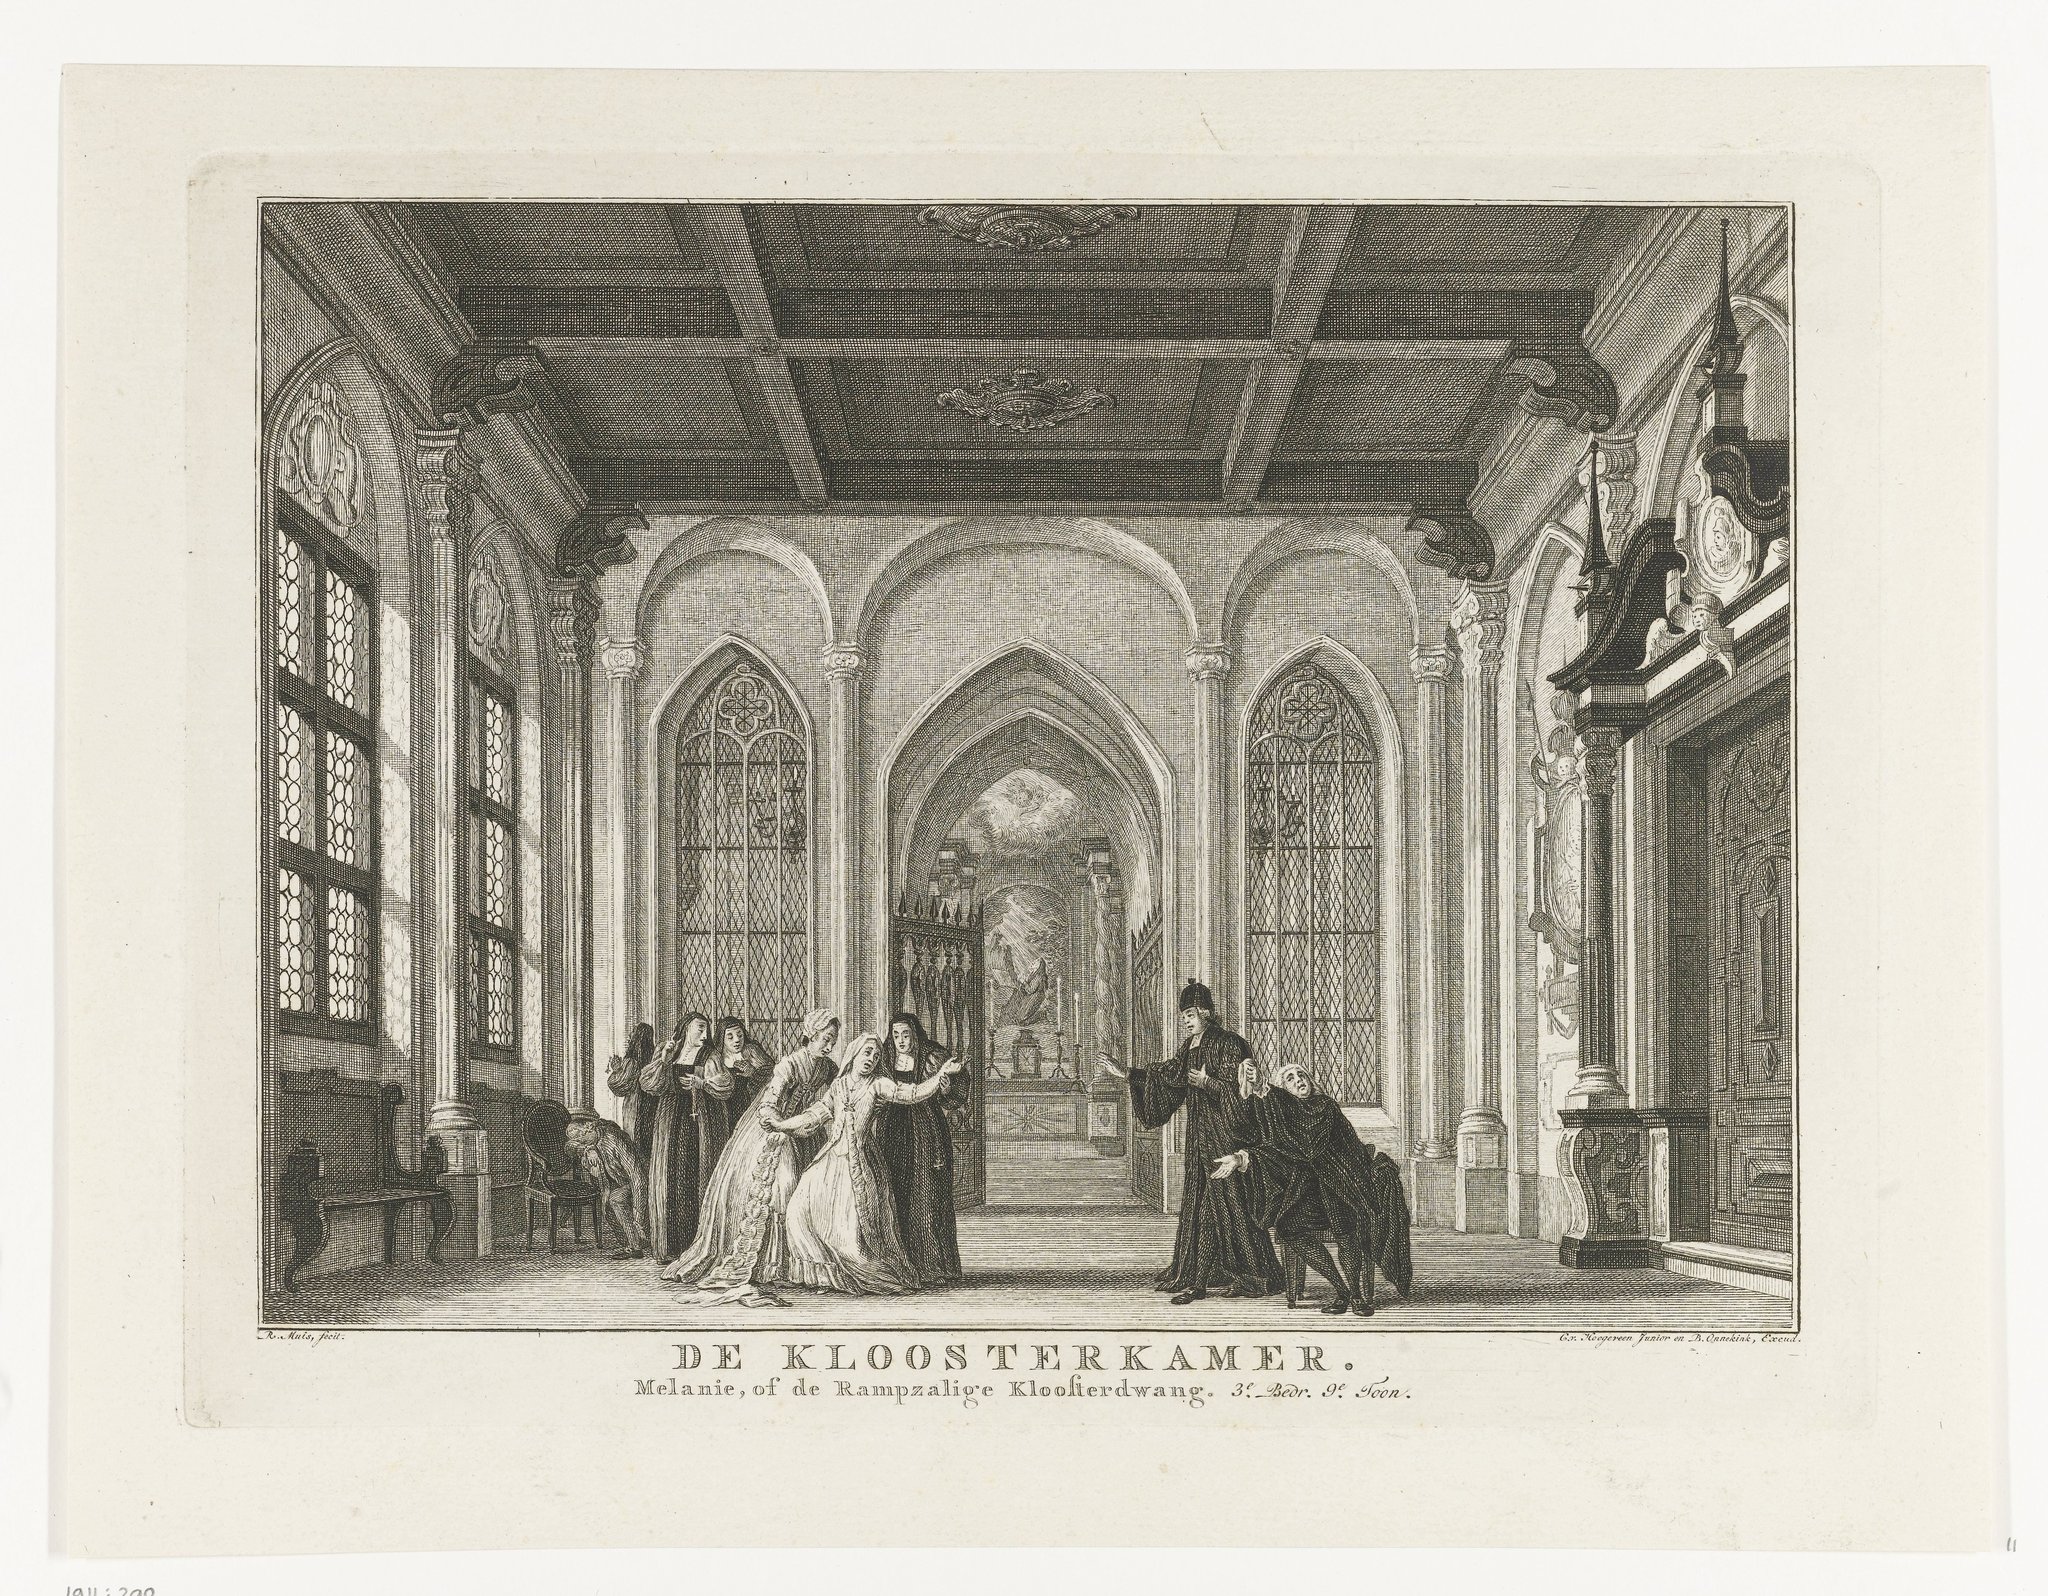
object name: print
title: De kloosterkamer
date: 1770-1825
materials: paper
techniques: engraving, etching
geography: leiden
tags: theatre, theatrical performance, abbey, monastery, convent ~ roman catholic church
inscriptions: collector's mark: Lugt 2228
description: In de kamer van een klooster ondersteunen twee vrouwen een jonge vrouw, Melanie. Achter hen staan drie nonnen en zit een treurende man. Links twee mannen. Op de achtergrond zicht in een kapel. De prent verbeeldt een toneelscène uit Melanie, of De rampzalige kloosterdwang, een treurspel van Jean-François de La Harpe over Melanie, die door haar vader wordt gedwongen van haar liefde voor een man af te zien en in het klooster in te treden.